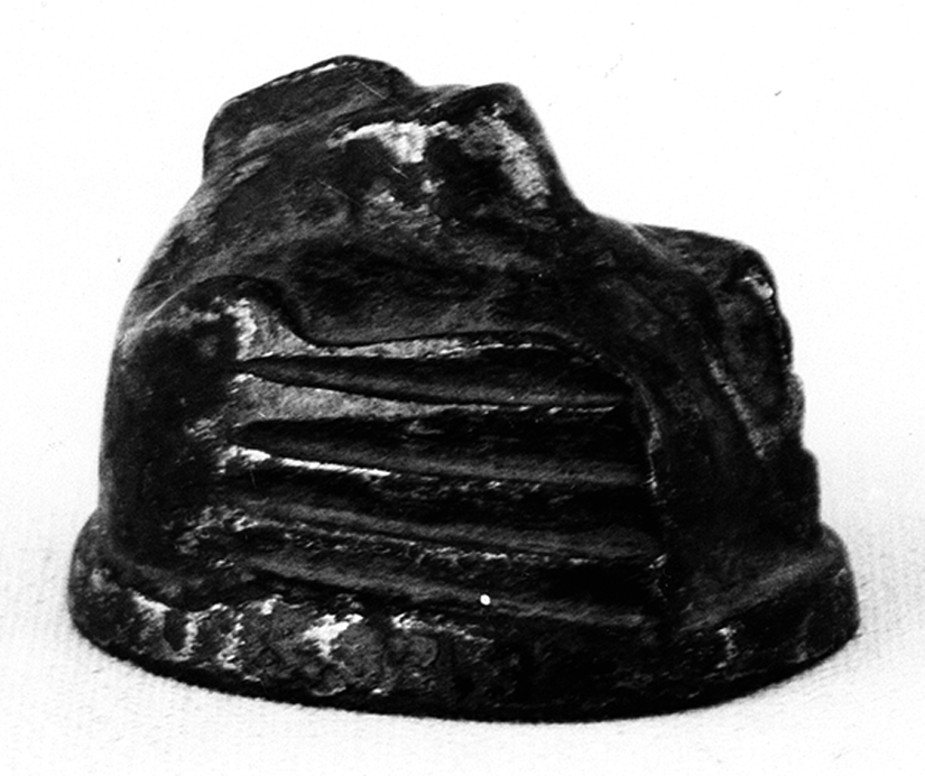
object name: figure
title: Figure of a swan or duck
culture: chinese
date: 618-907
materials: gilt bronze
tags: birds